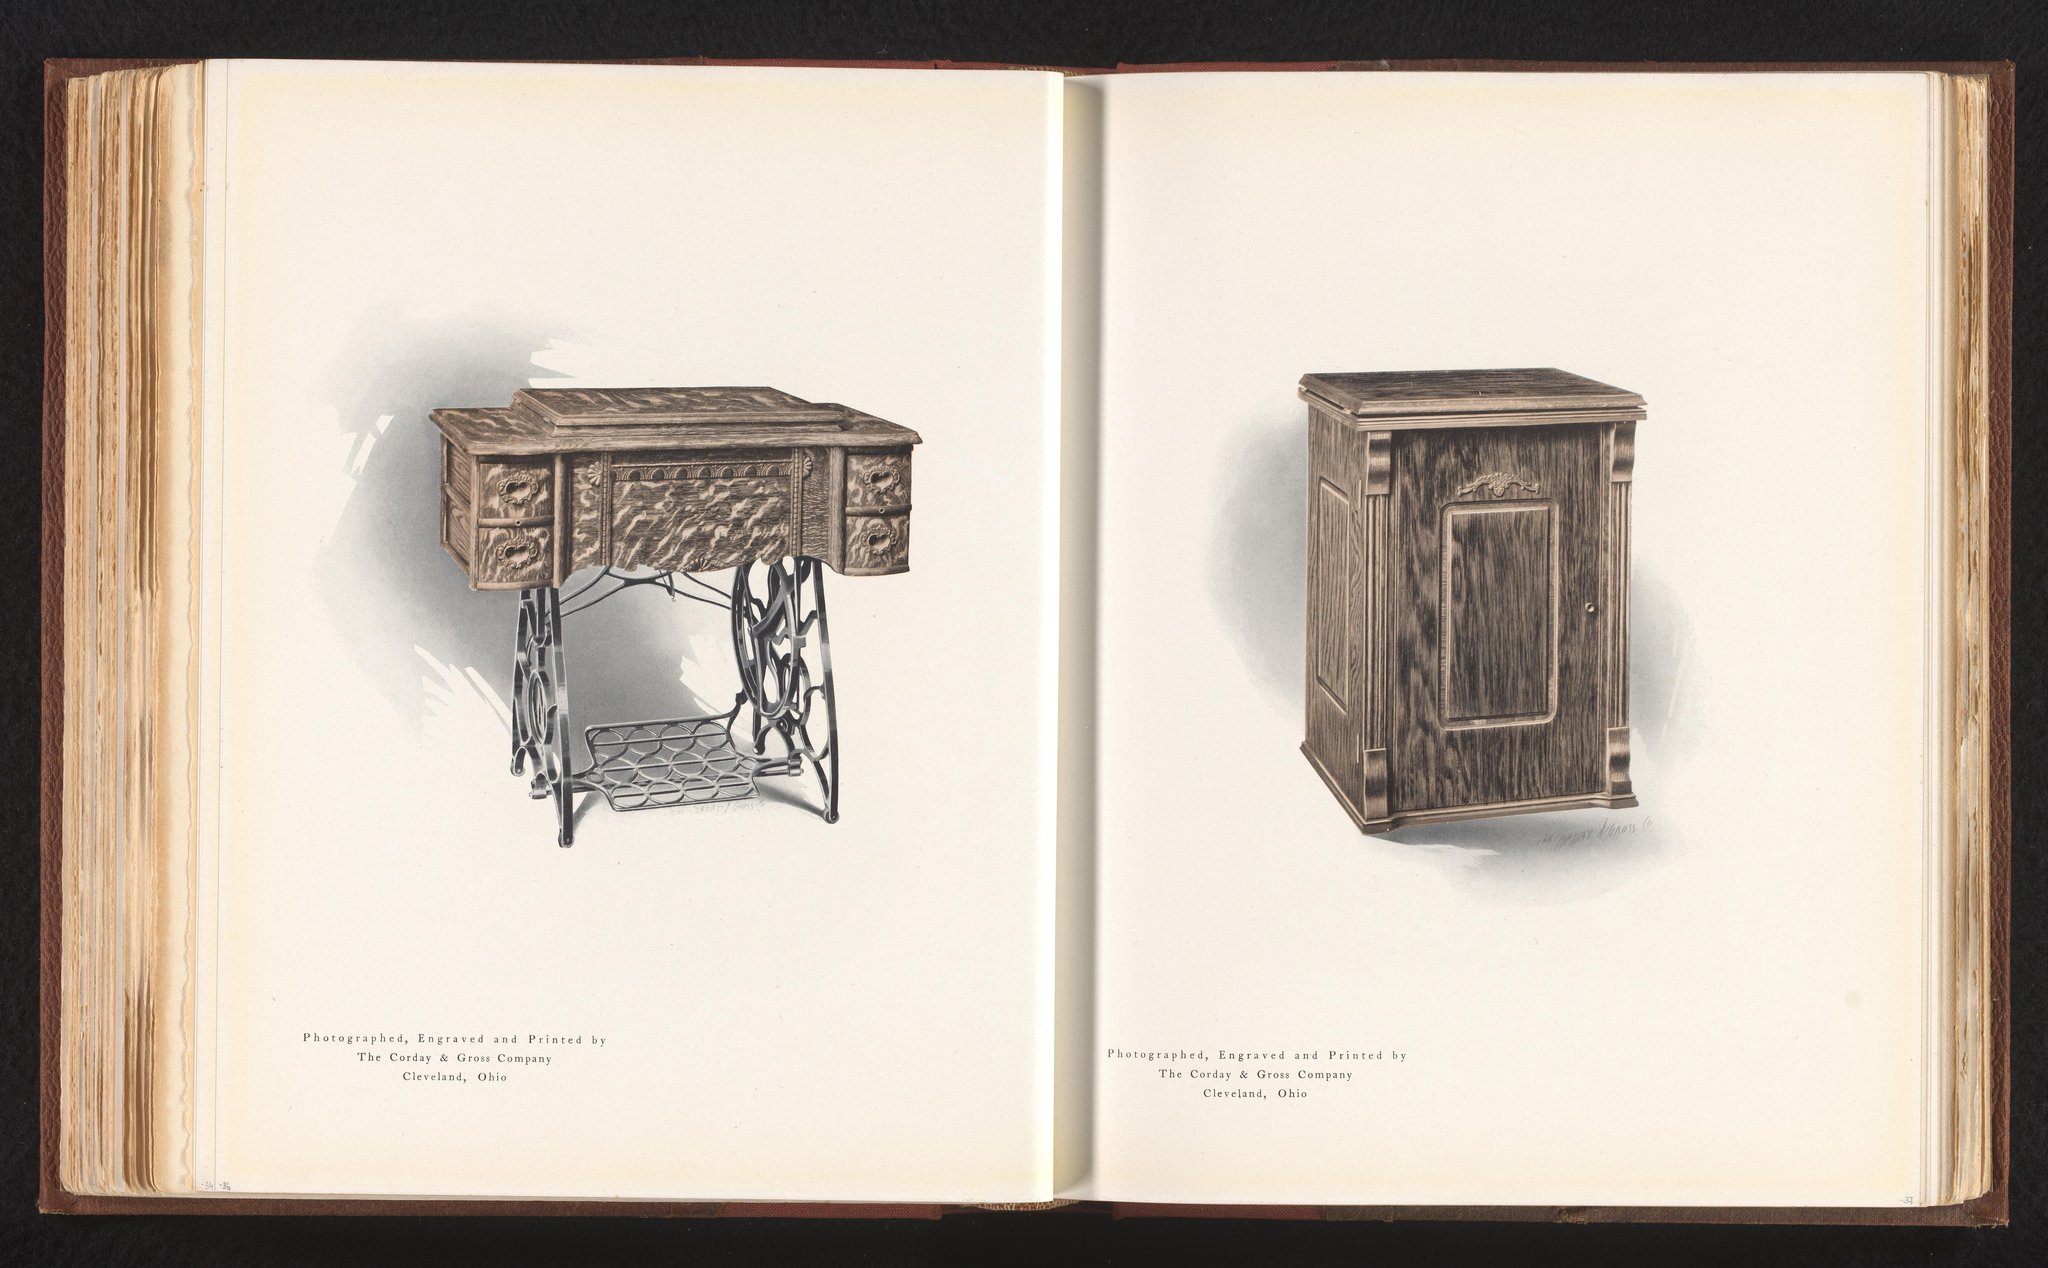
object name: photomechanical print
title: Naaitafel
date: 1904-1909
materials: paper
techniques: color autotype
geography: ohio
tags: furniture to put things on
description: Prent op negende ongenummerde pagina na pagina 213.